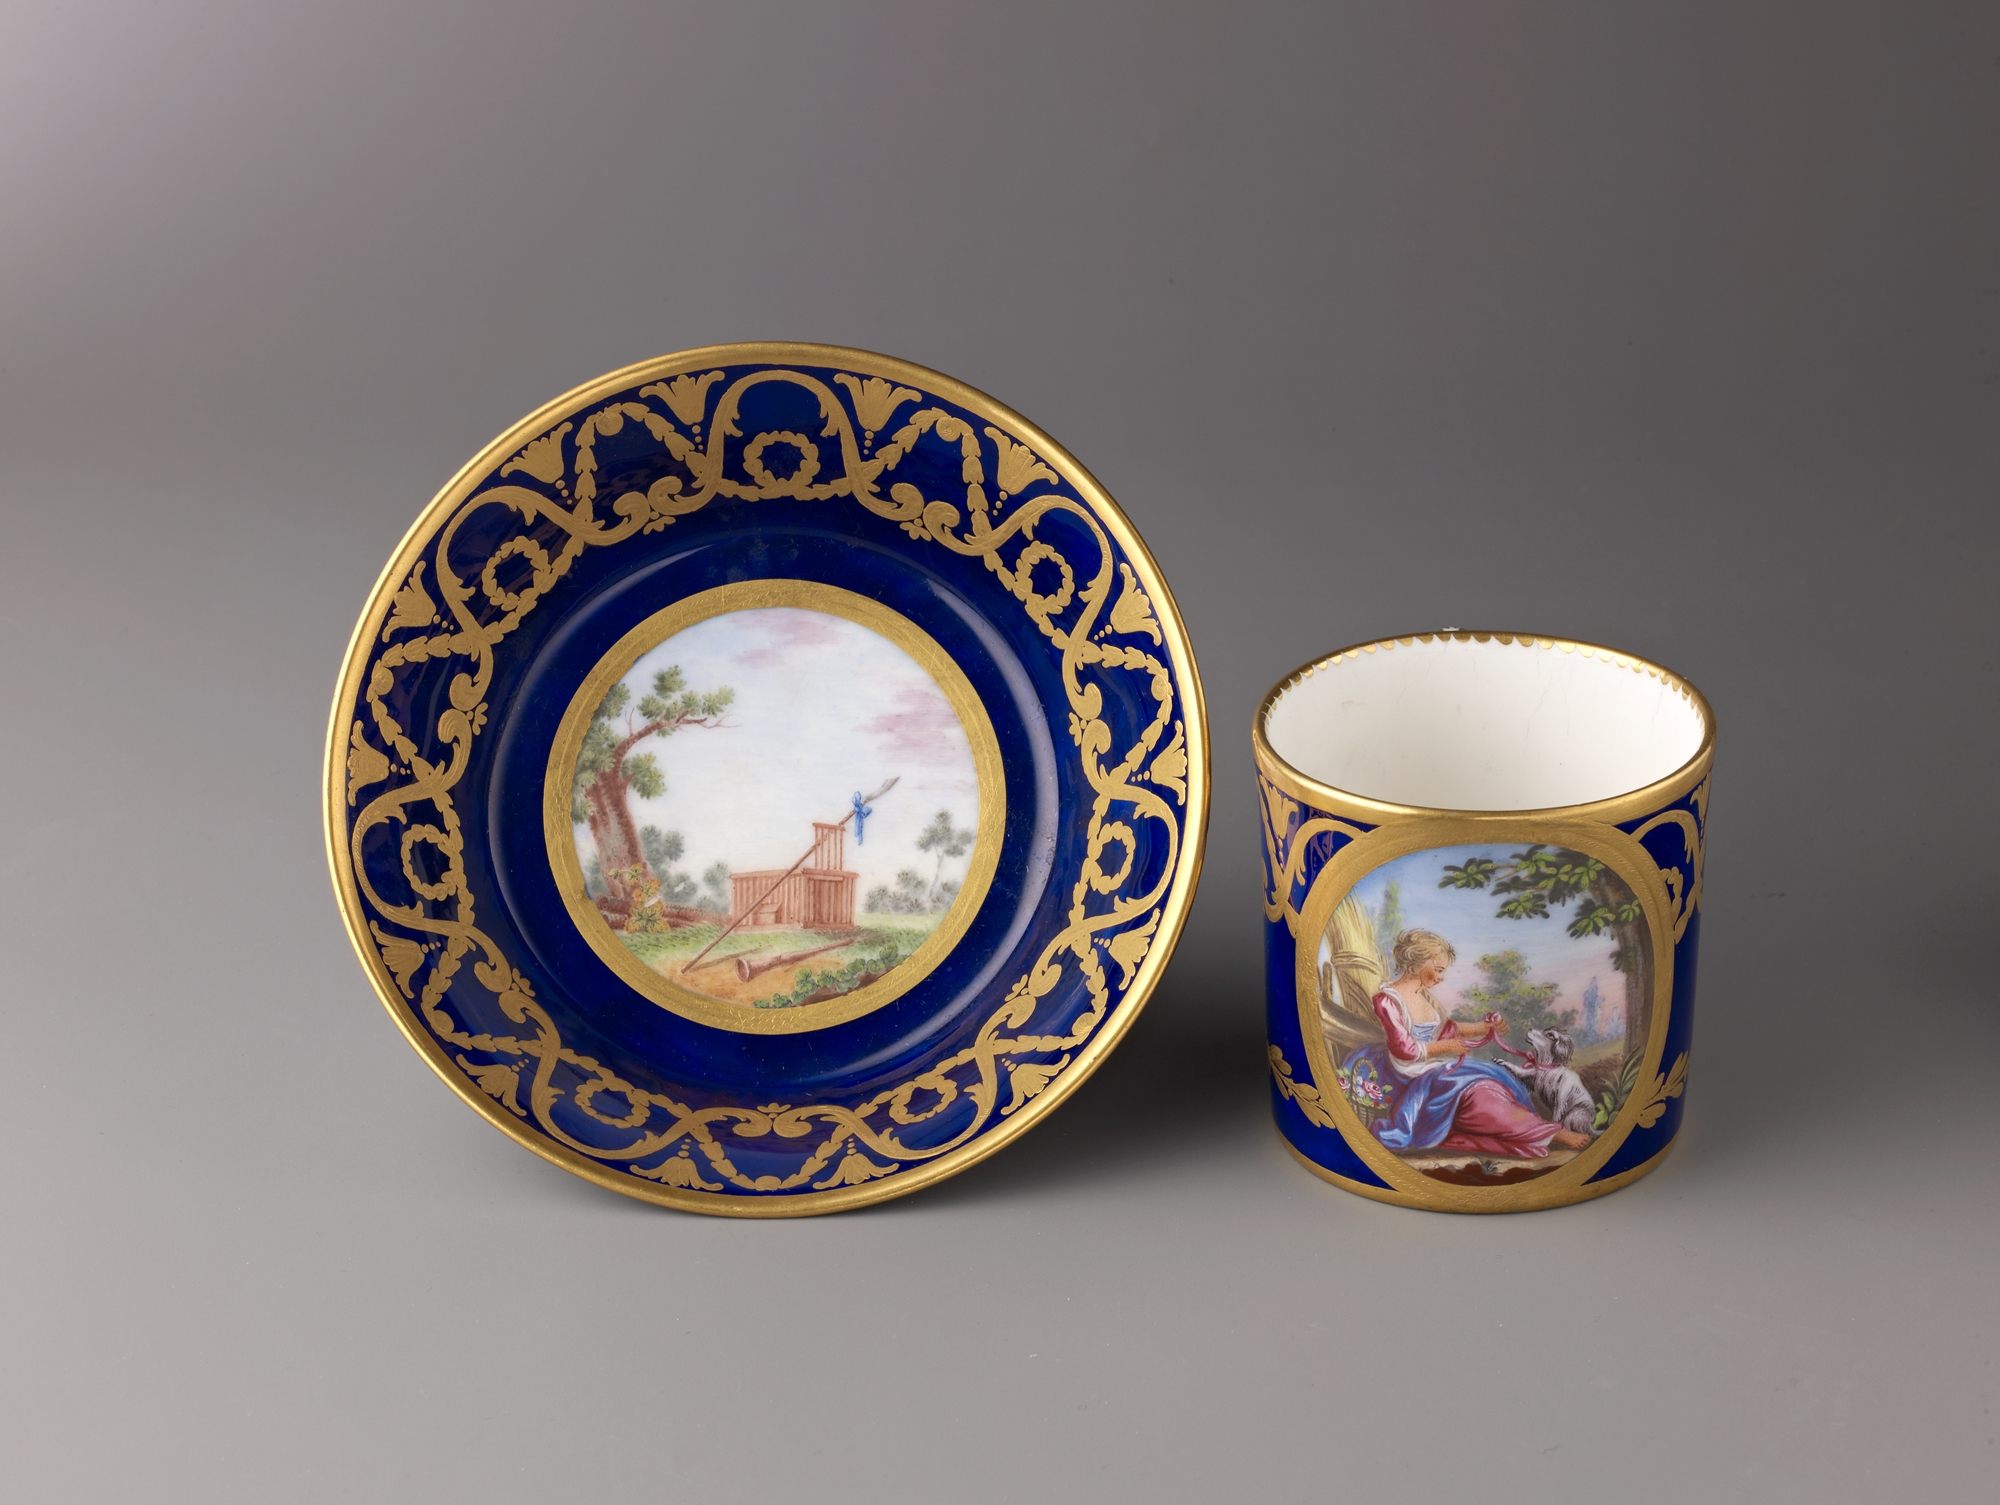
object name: cup and saucer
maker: jean etienne chabry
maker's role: artist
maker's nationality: french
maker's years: 1749-1787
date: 1777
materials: soft paste porcelain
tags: spears,women,dogs